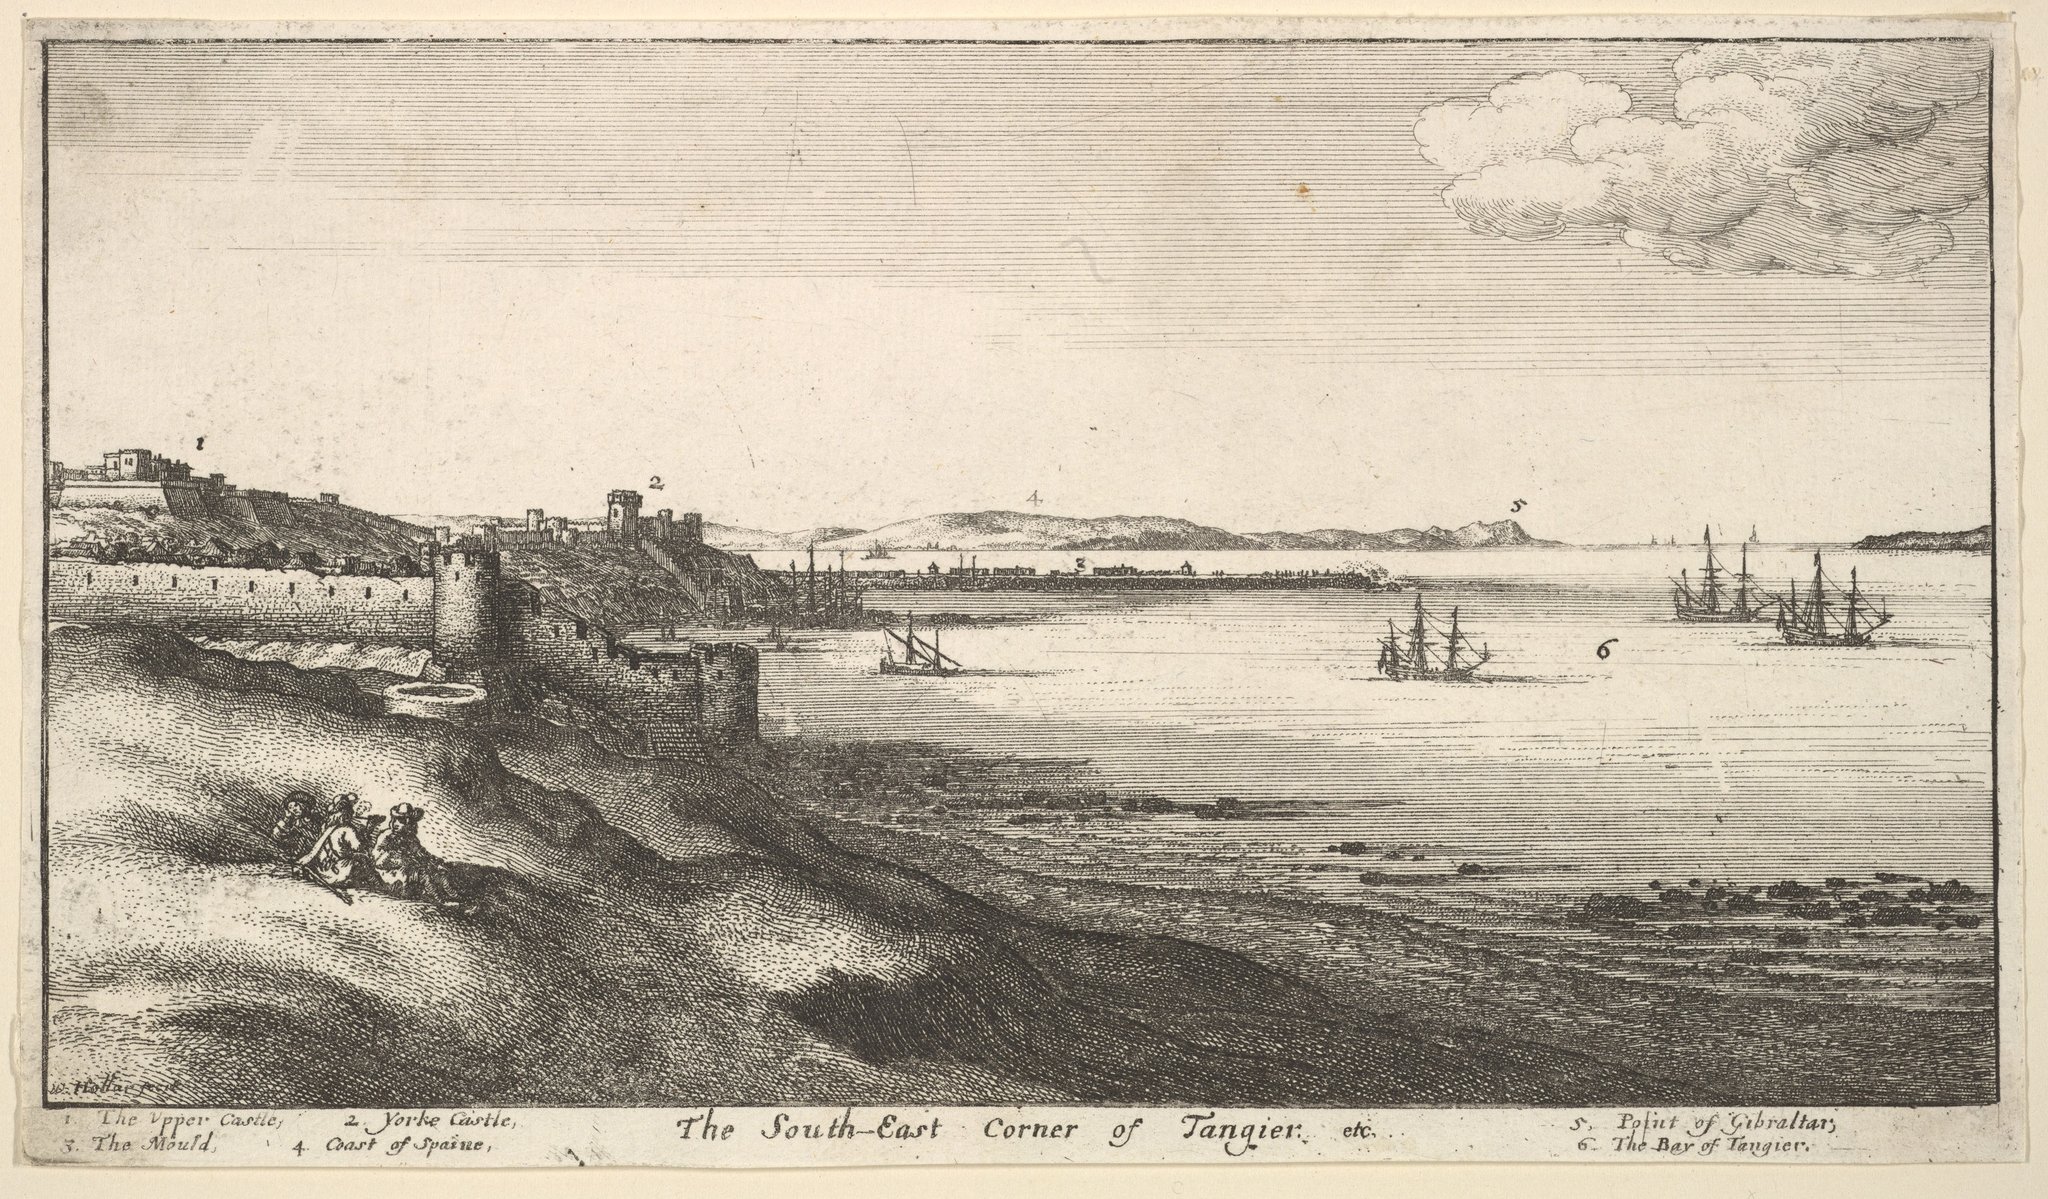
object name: print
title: South East Corner of Tangier, from "Views of Tangier"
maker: wenceslaus hollar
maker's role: artist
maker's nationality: bohemian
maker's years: 1607-1677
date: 1669-1673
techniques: etching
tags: buildings,boats